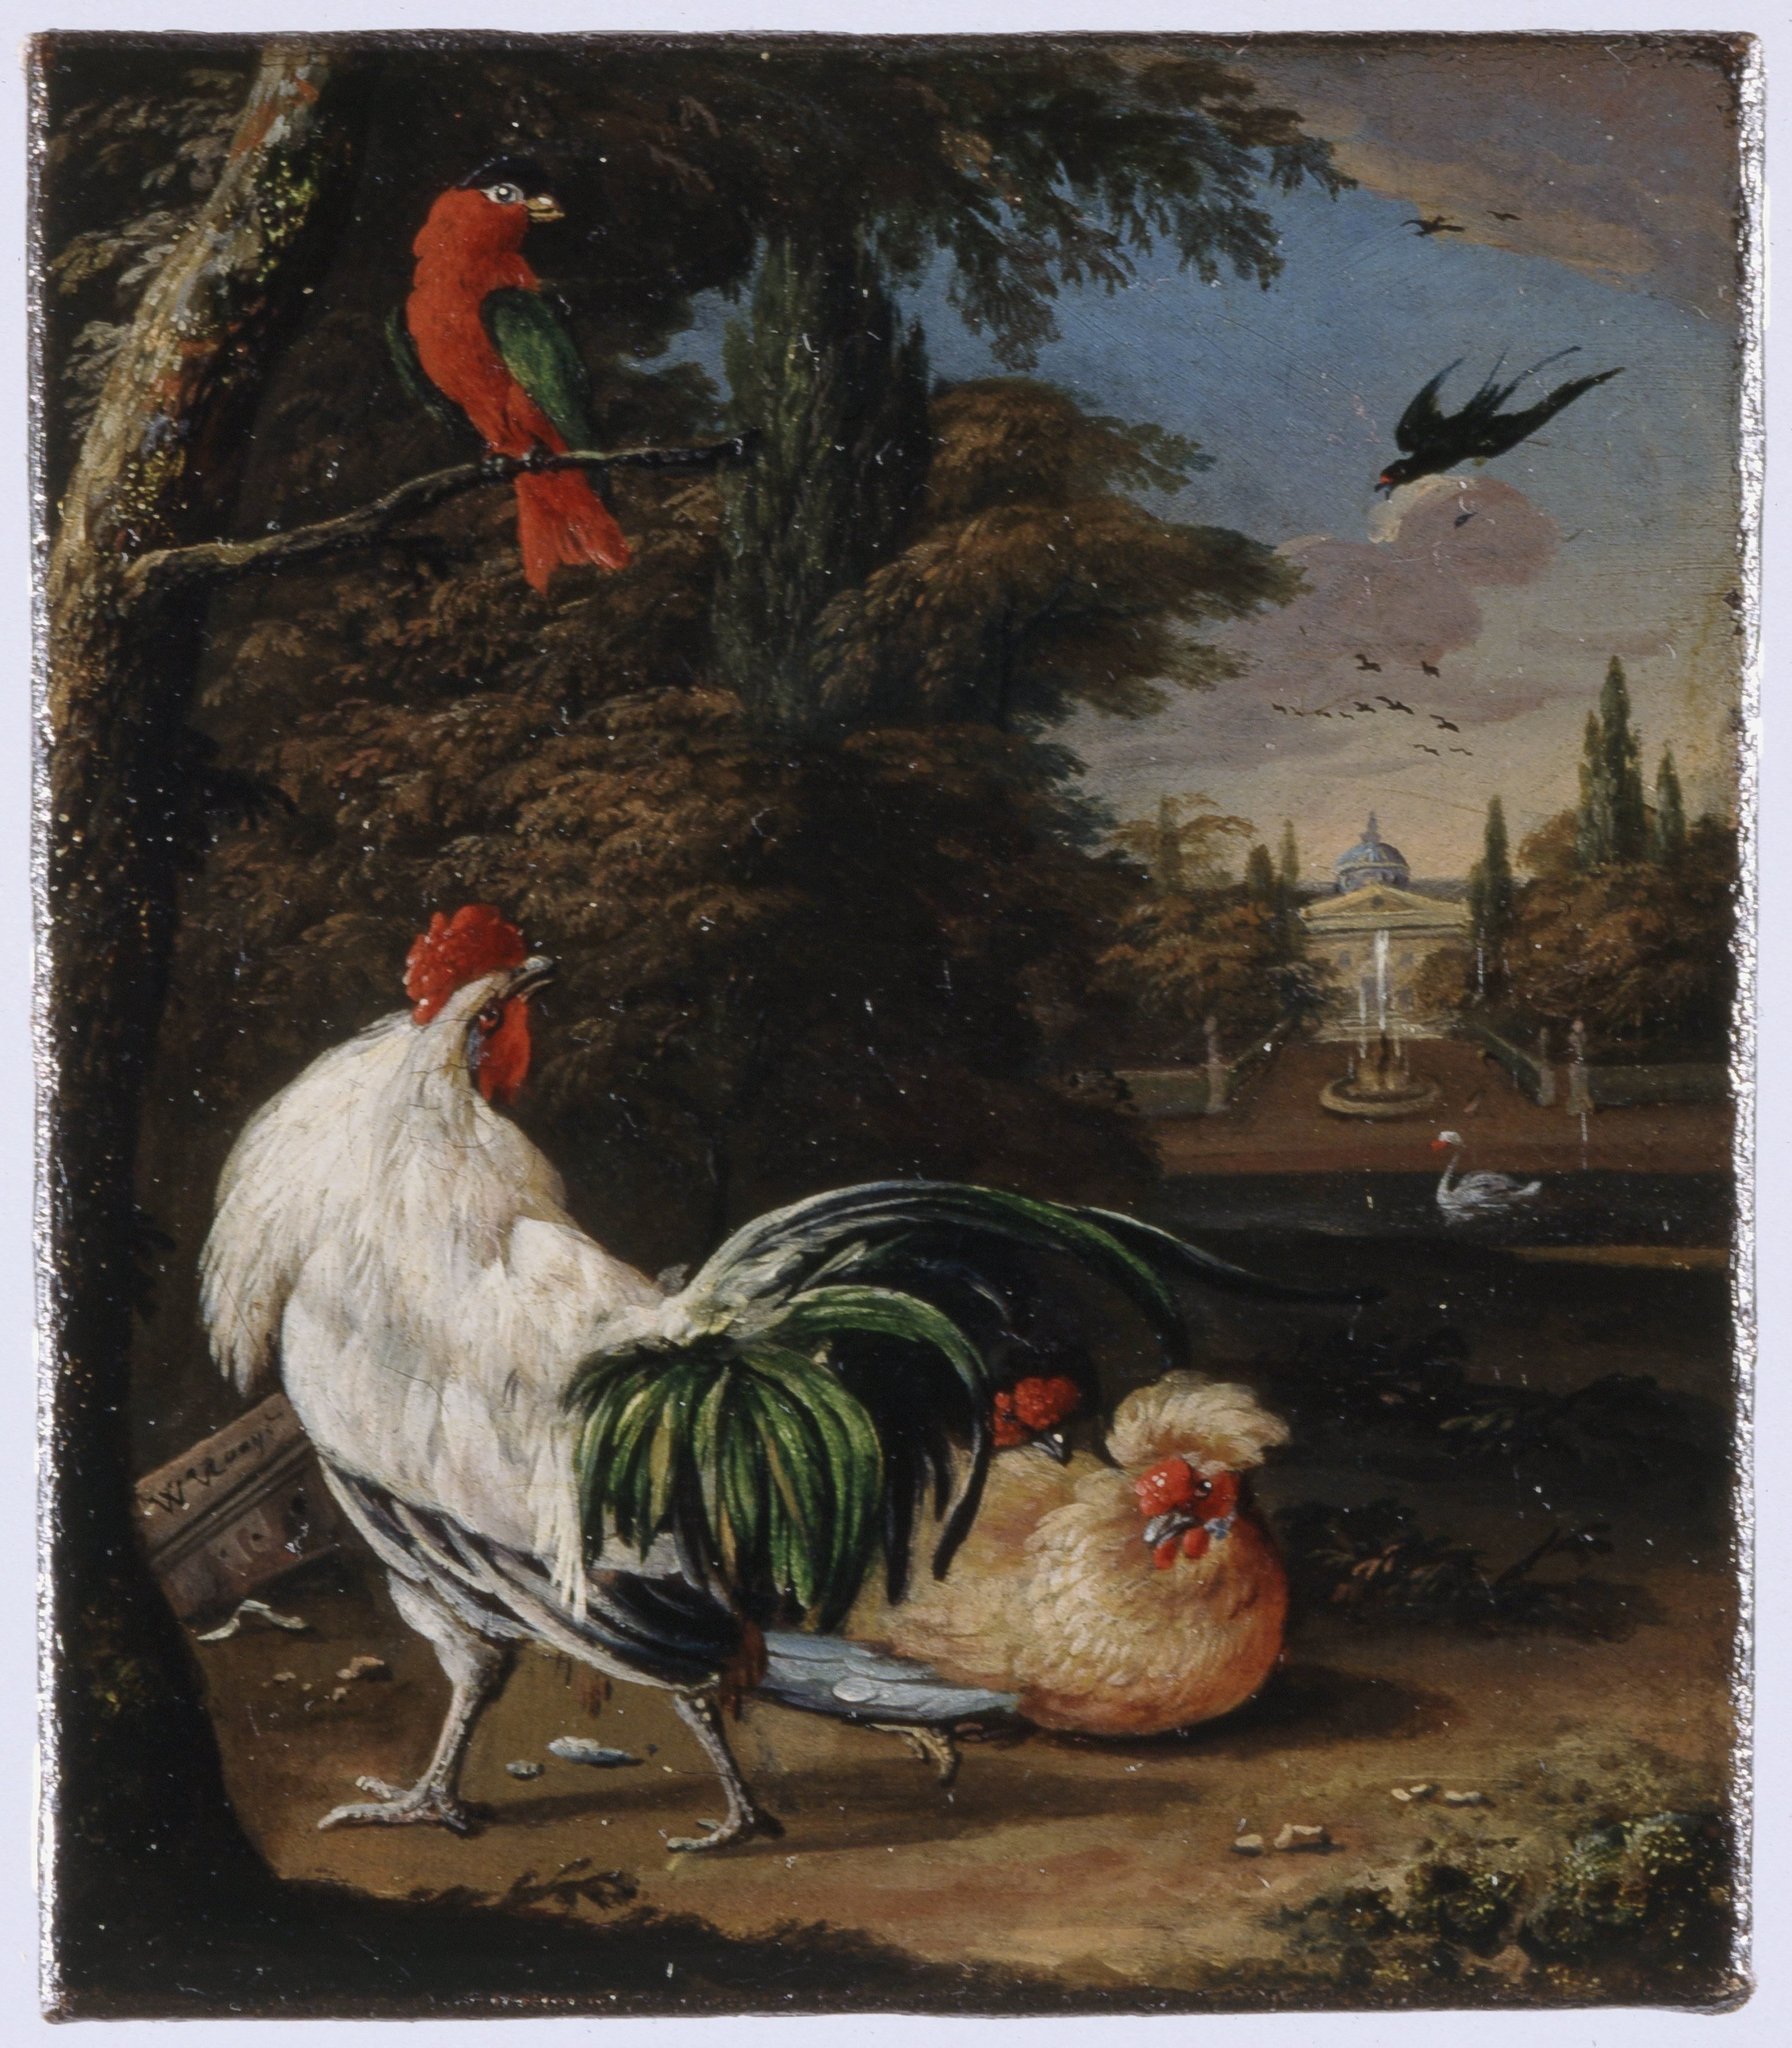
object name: miniature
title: Vogels in een park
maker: willem hendrik wilhelmus van royen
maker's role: draughtsman, painter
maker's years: 1672-1742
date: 1690-1710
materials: canvas, oil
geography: amsterdam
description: Schoorsteenstuk in de zaal van een poppenhuis; op de voorgrond drie sierhoenders en een roodgroene papegaai, in een parkachtige omgeving met rechts een vijver, fontein en uitzicht op een villa met koepeldak. Gesigneerd: W.v. Rooye. (Hendrik Wilhelmus)